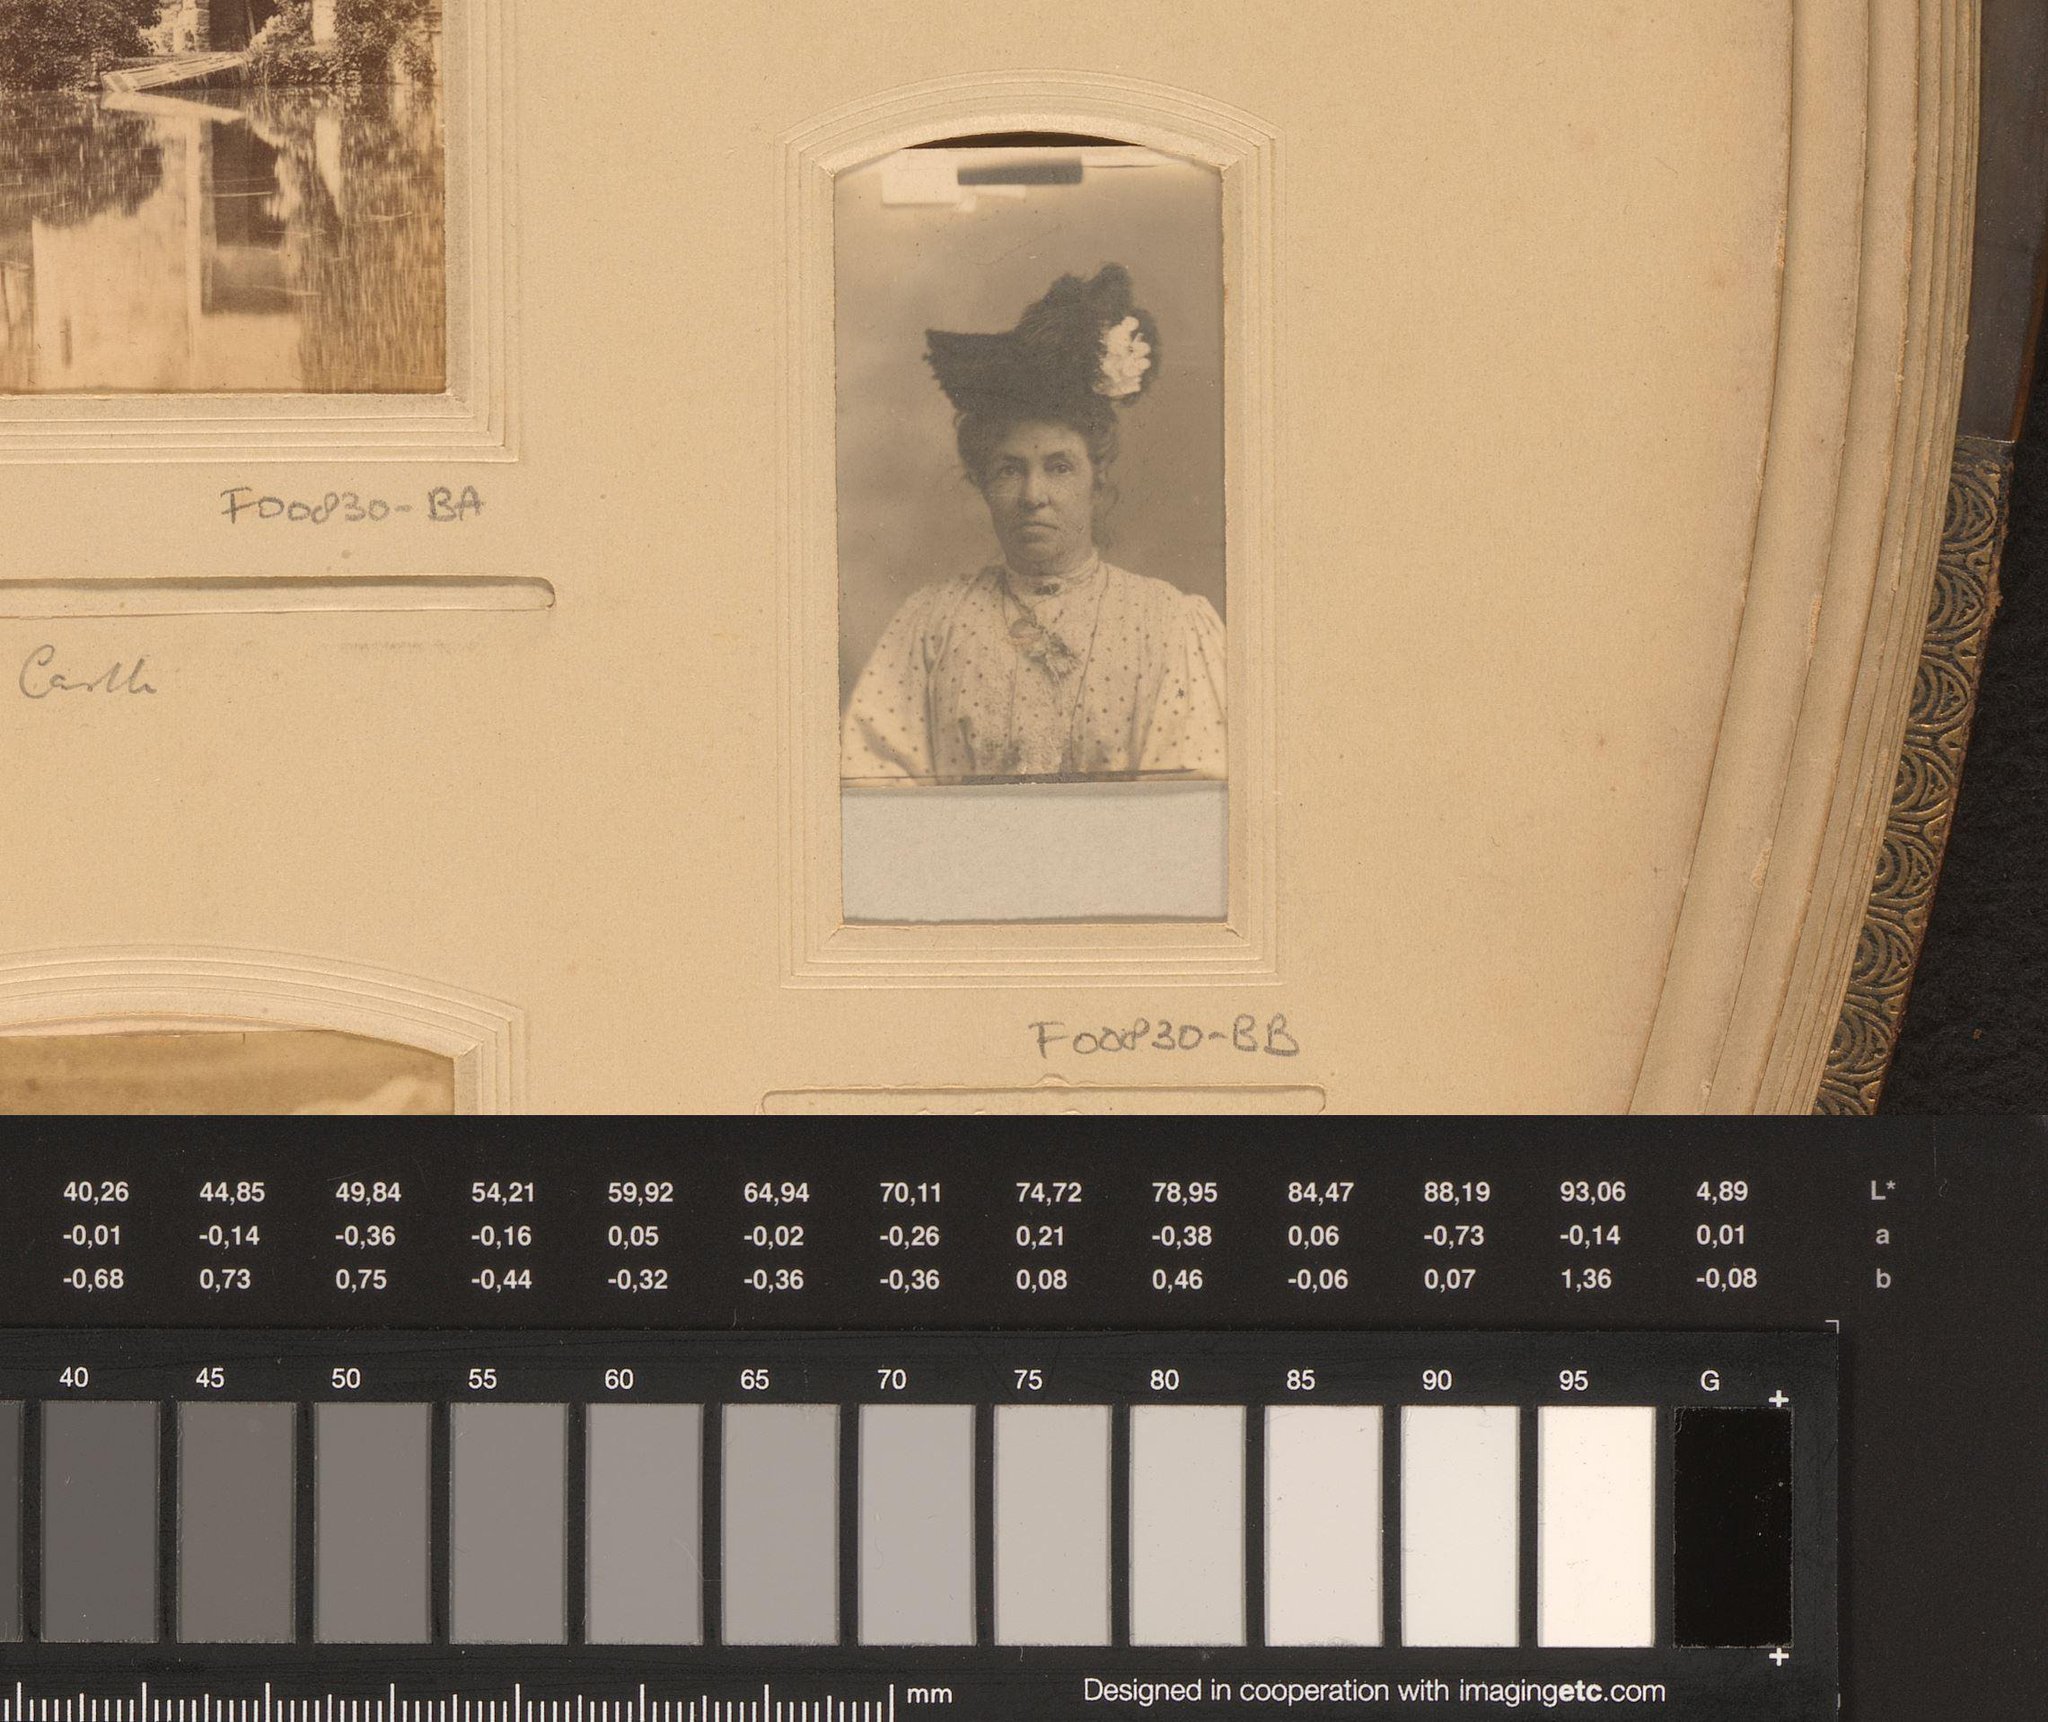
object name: album leaf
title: Portret van een vrouw met hoed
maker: Anonymous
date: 1890-1910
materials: photographic support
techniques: gelatin silver print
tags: adult woman, historical persons, head-gear: hat